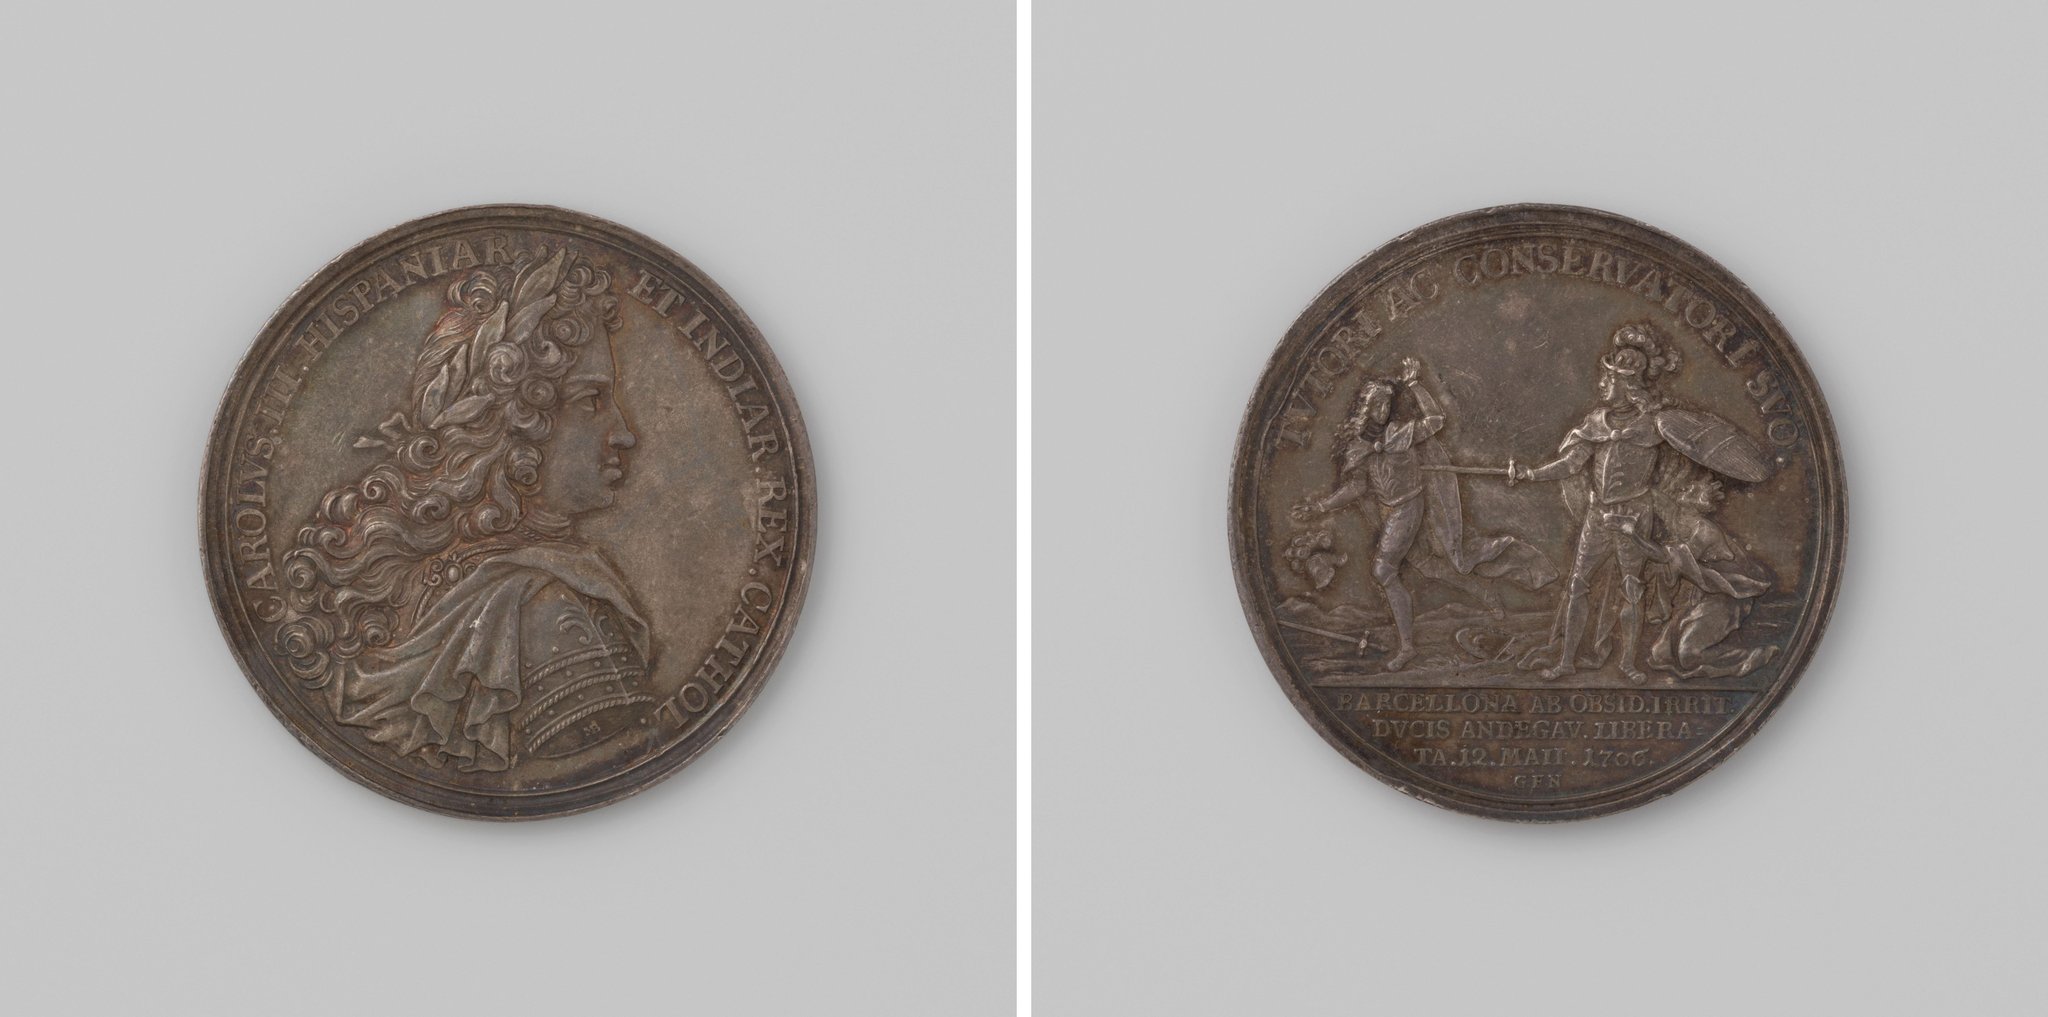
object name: history medal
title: Ontzet van Barcelona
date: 1706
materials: silver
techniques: striking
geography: nuremberg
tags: filips v (koning van spanje), vienna, charles vi (holy roman emperor)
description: Zilveren penning. Voorzijde: borststuk man met lauwerkrans binnen omschrift. Keerzijde: Karel III beschermt met zijn schild Barcelona, in gedaante van vrouw die smekend aan zijn voeten ligt, en verjaagt met zwaard Filips V, die zijn wapens weggooit en op vlucht slaat binnen omschrift; afsnede: opschrift.